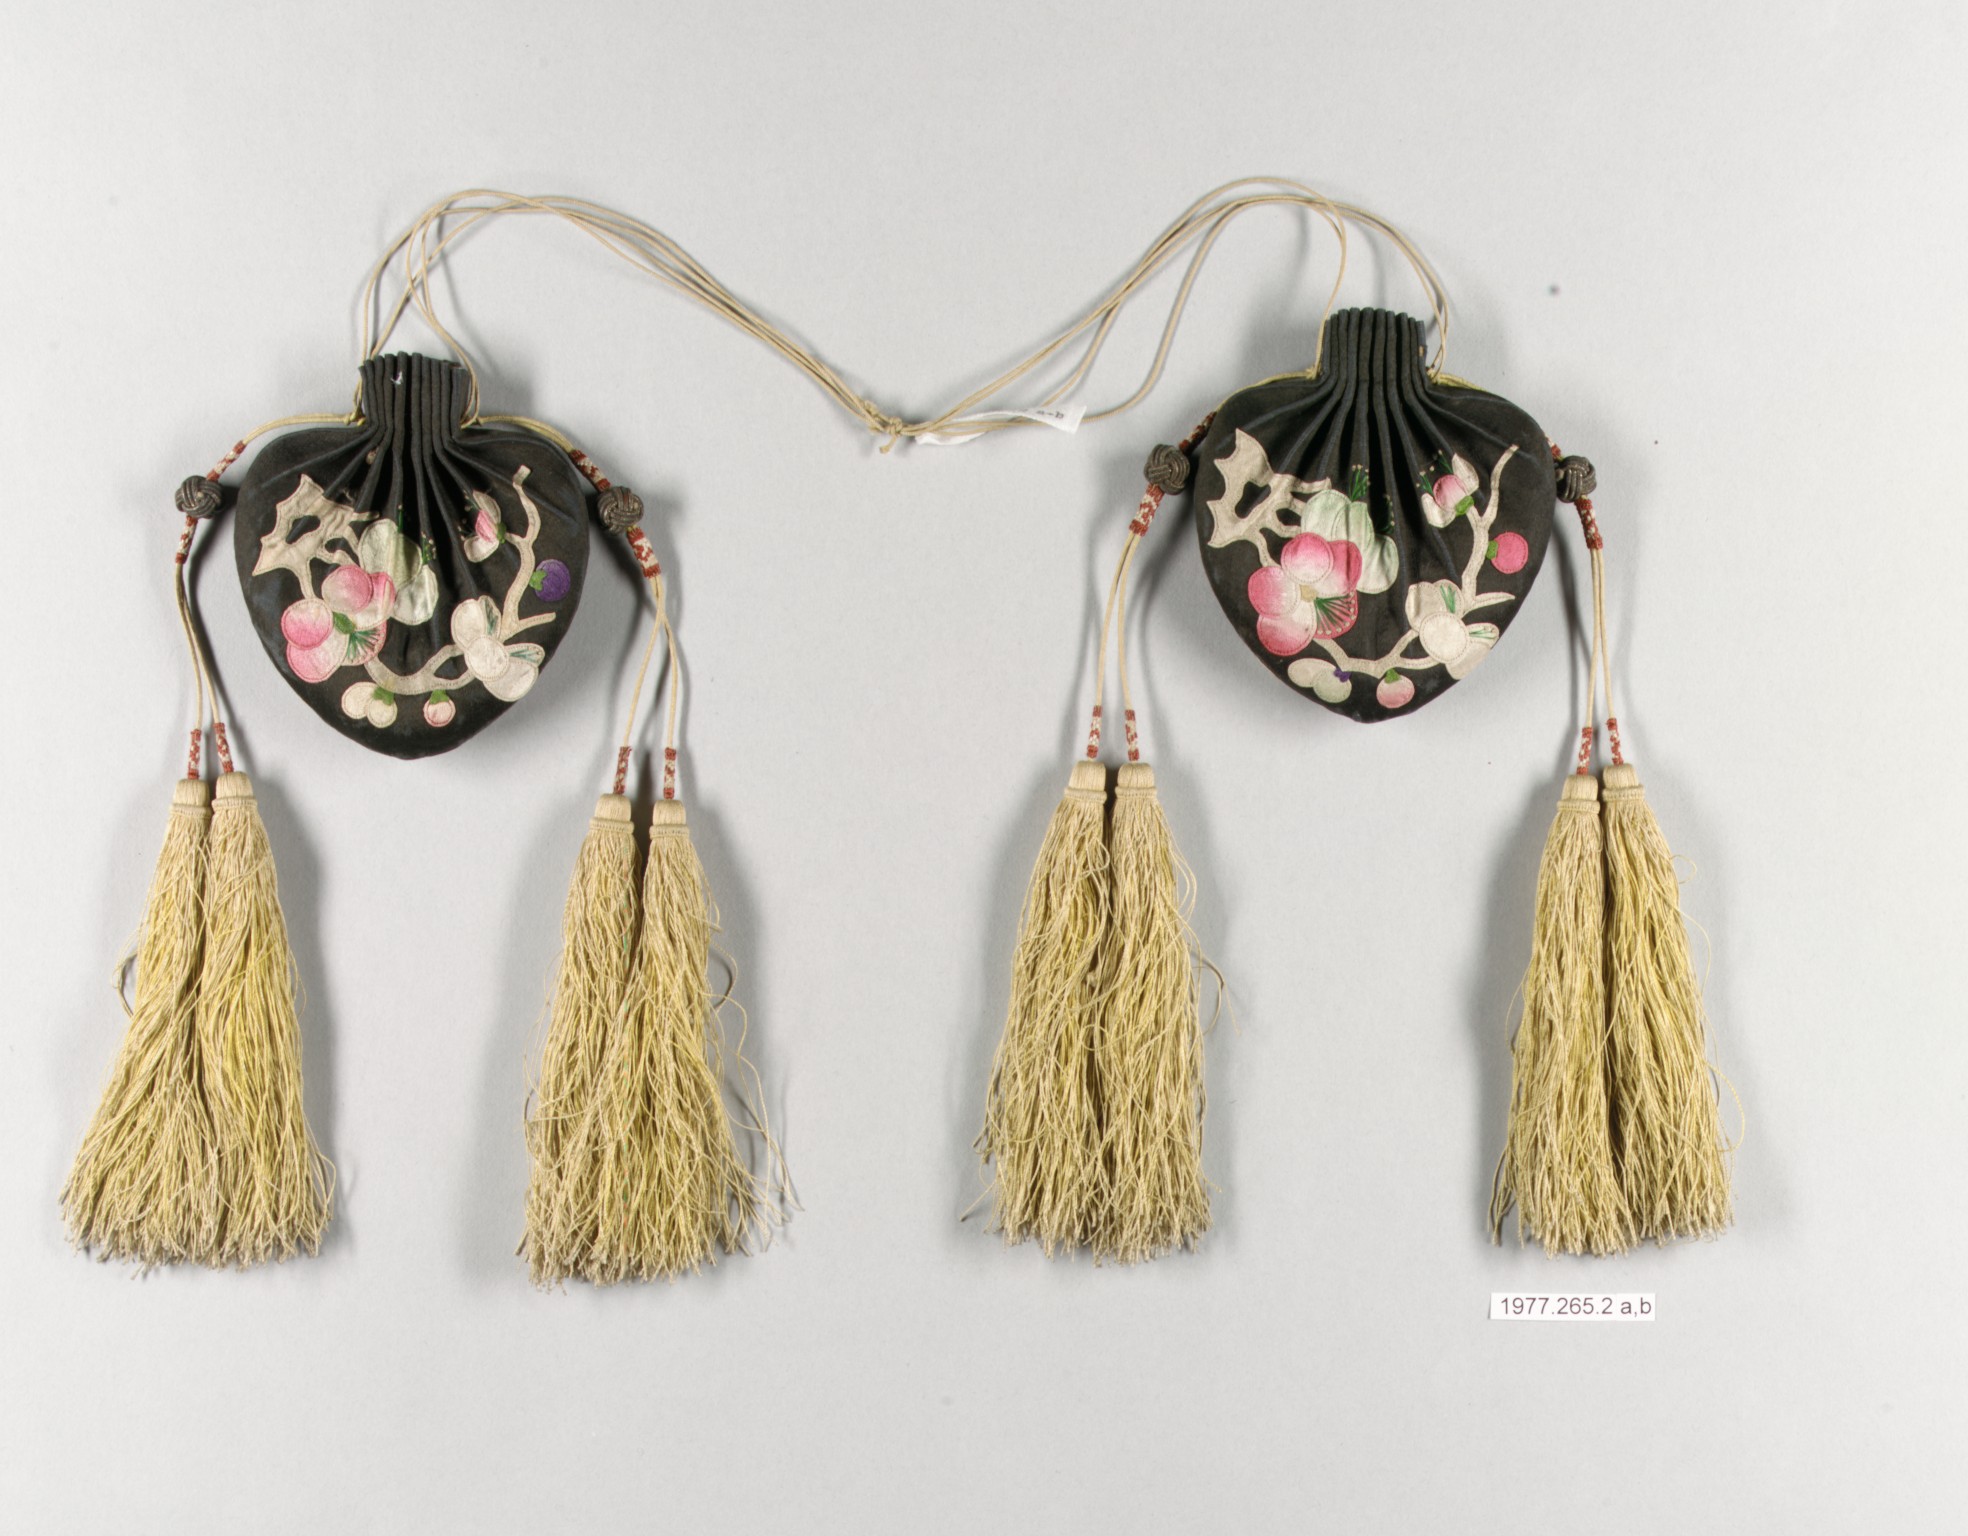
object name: bag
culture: chinese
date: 1867-1900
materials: silk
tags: flowers